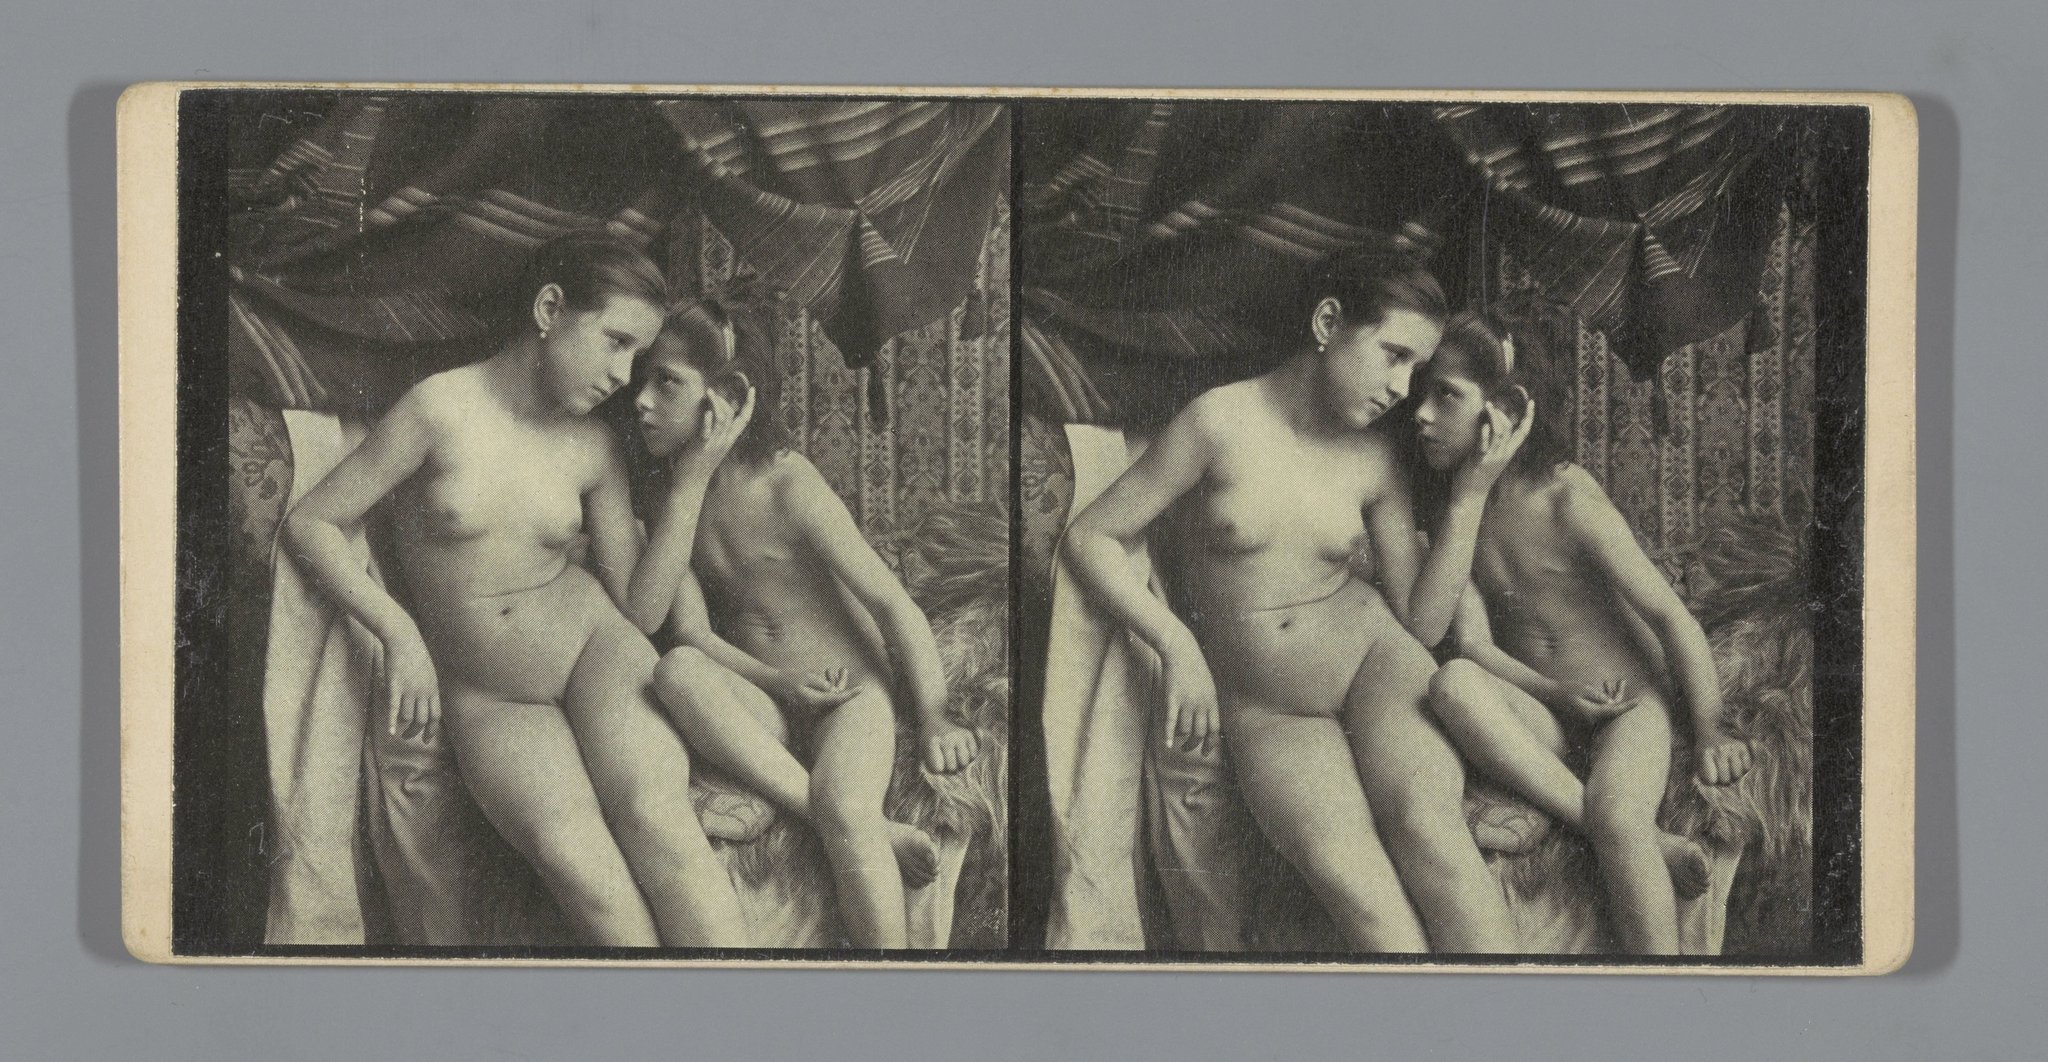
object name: stereograph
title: Tafereel met twee naakte meisjes op een sofa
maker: Anonymous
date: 1873-1910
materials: cardboard, paper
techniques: autotype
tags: woman (showing herself) undressed, quasi-nude